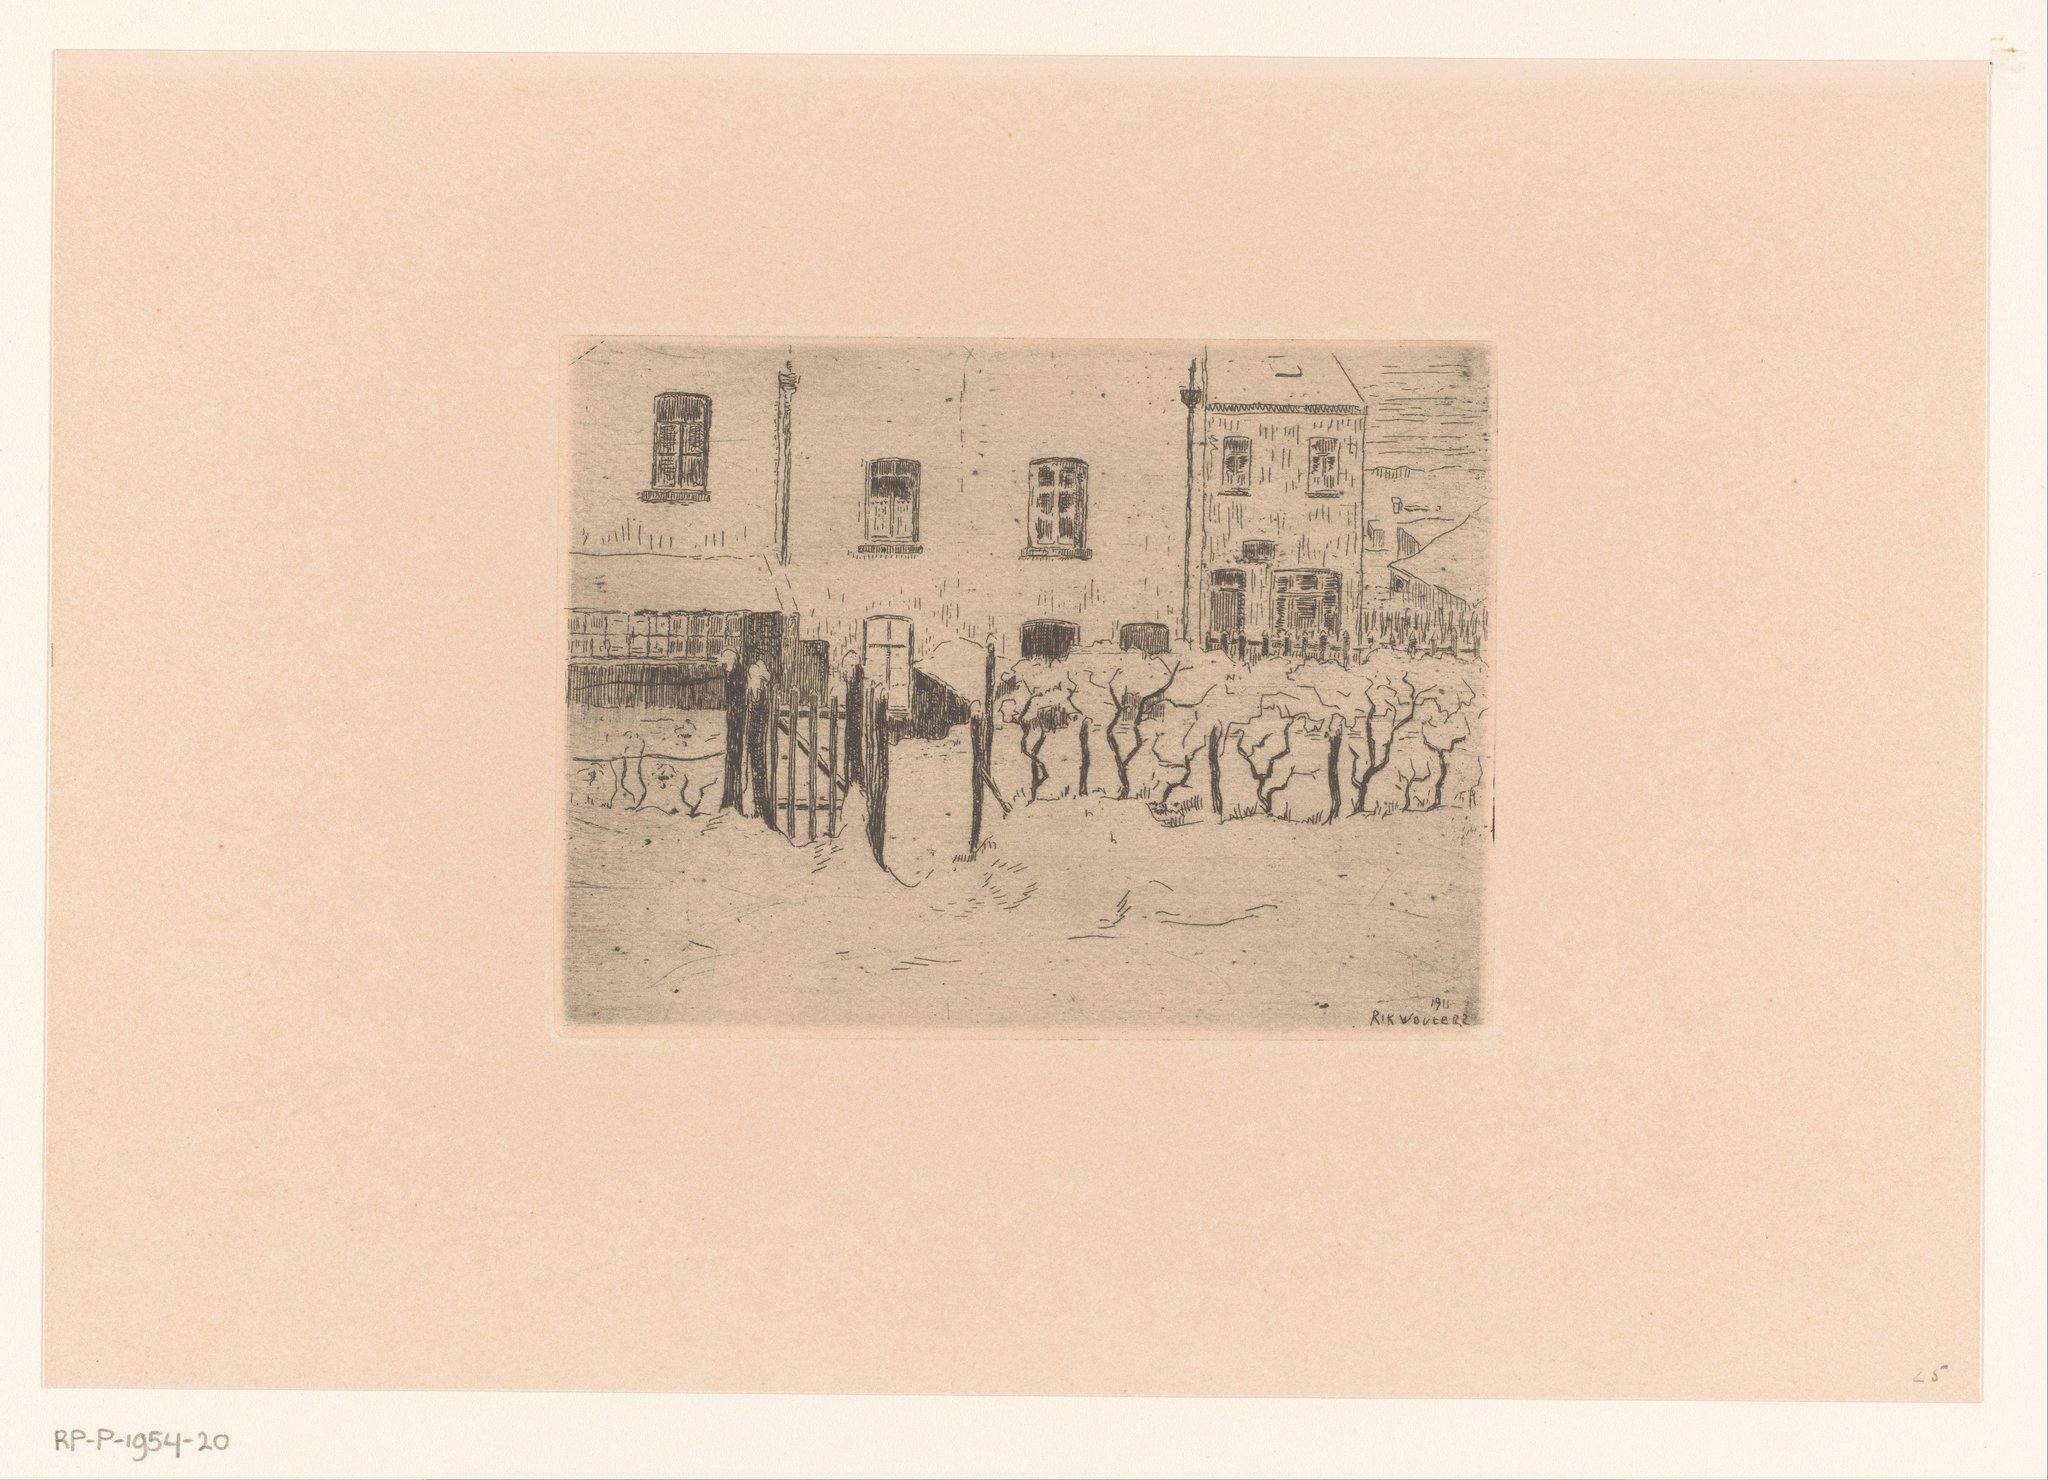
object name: print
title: Huizen achter een besneeuwde heg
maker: rik wouters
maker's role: draughtsman, print maker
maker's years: 1882-1916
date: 1911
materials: paper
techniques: etching, intaglio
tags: village, snow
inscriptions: collector's mark: Lugt 2228